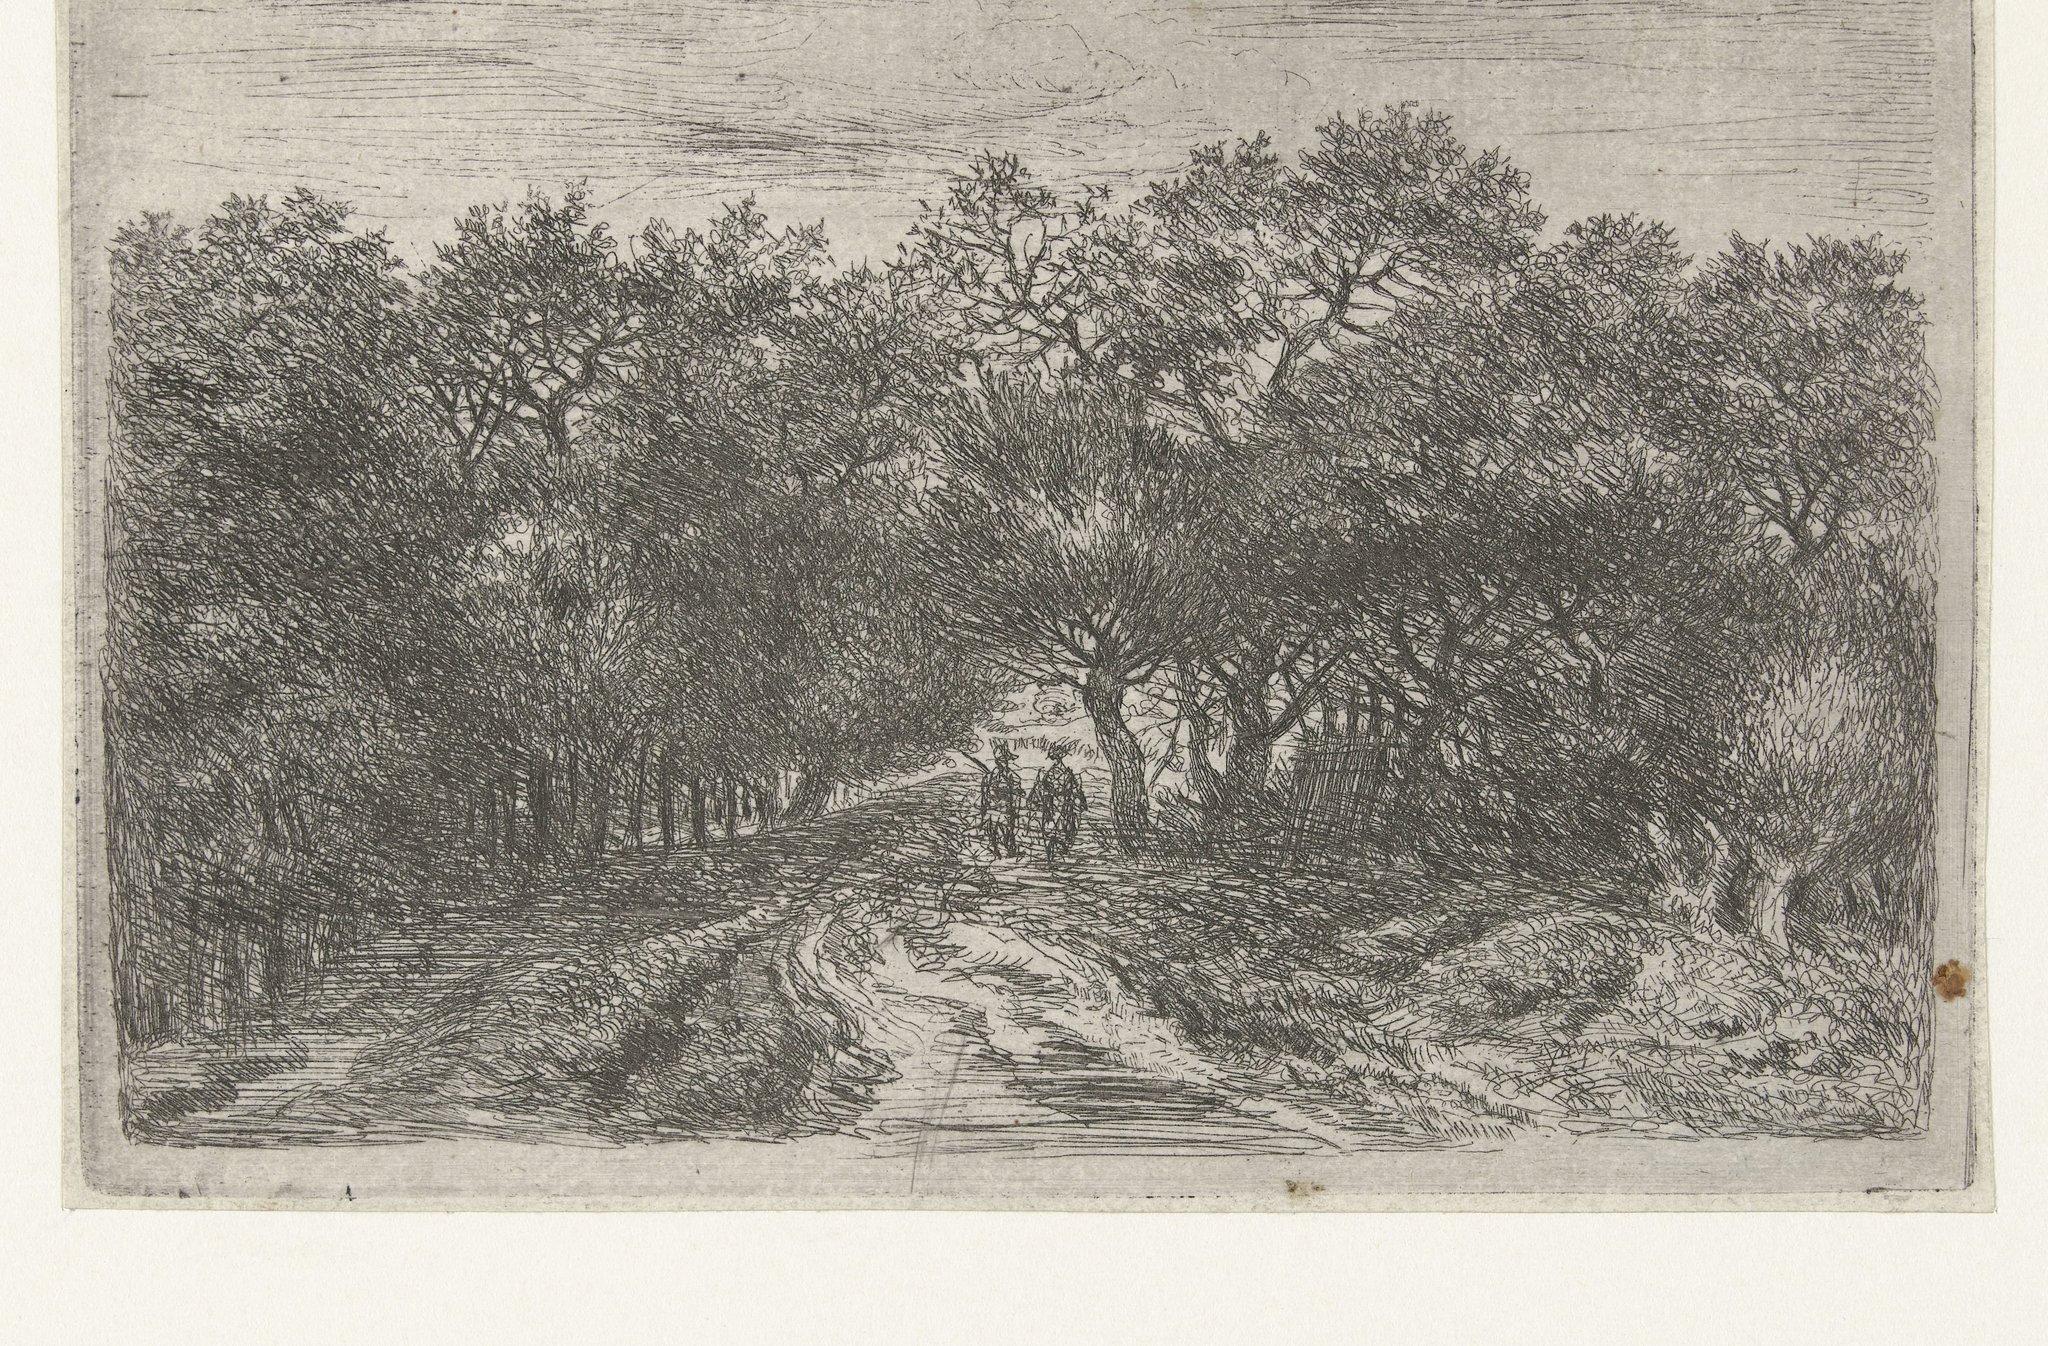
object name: print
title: Bospad met twee figuren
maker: johan de lagoor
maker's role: draughtsman, painter, print maker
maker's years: 1620-1660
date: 1635-1660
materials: paper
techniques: etching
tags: forest path or lane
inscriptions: collector's mark: Lugt 2228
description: Bosgezicht met twee figuren lopend op een pad.